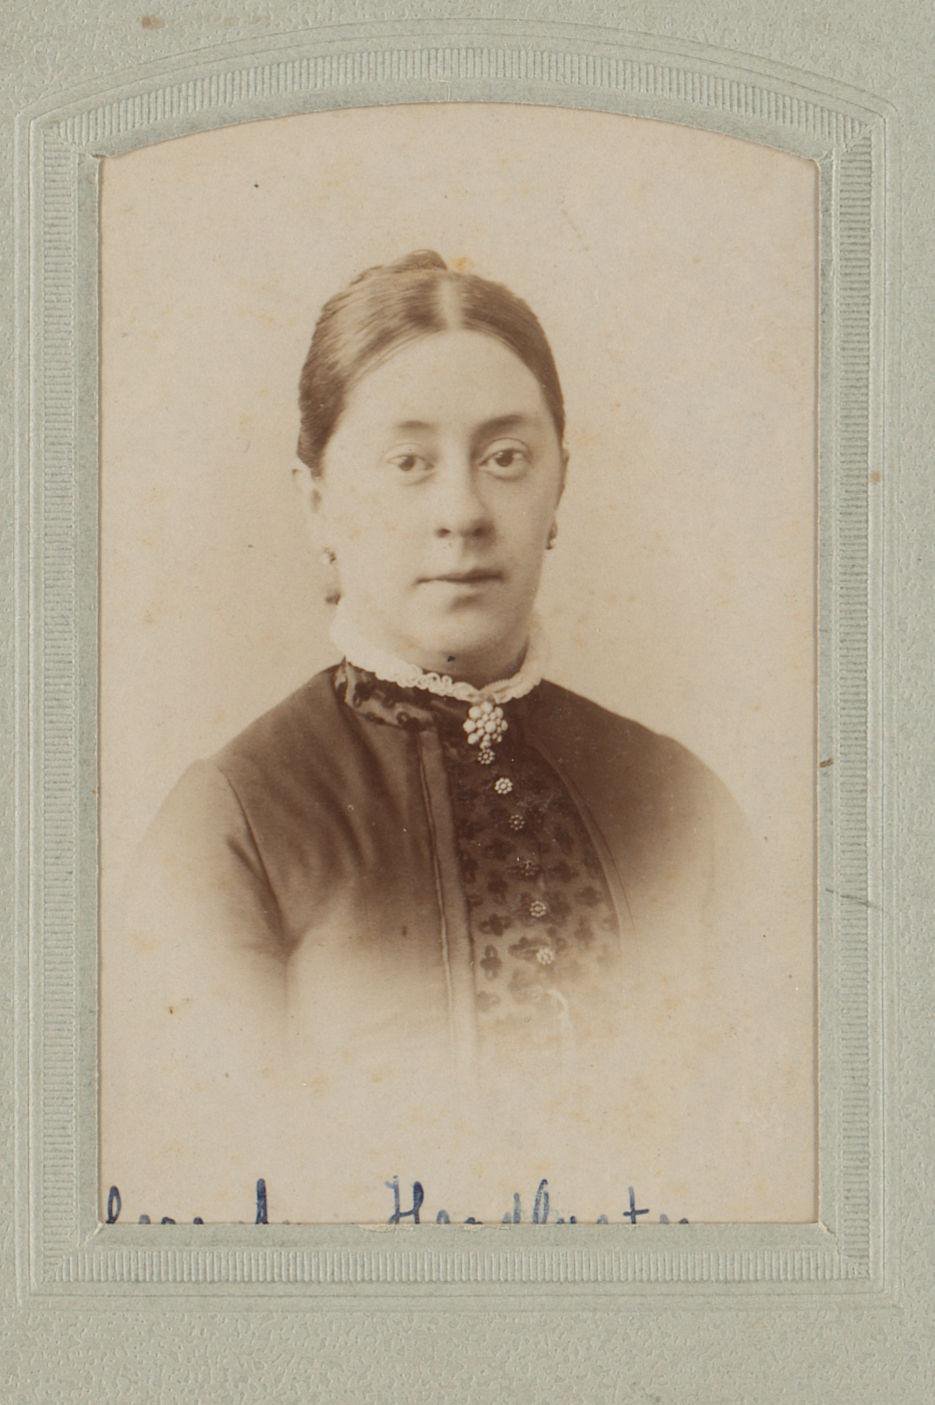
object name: album leaf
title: Portret van een vrouw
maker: max büttinghausen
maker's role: fotograaf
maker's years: 1847-1906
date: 1890-1910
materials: cardboard, photographic support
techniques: albumen print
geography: amsterdam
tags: adult woman, historical persons